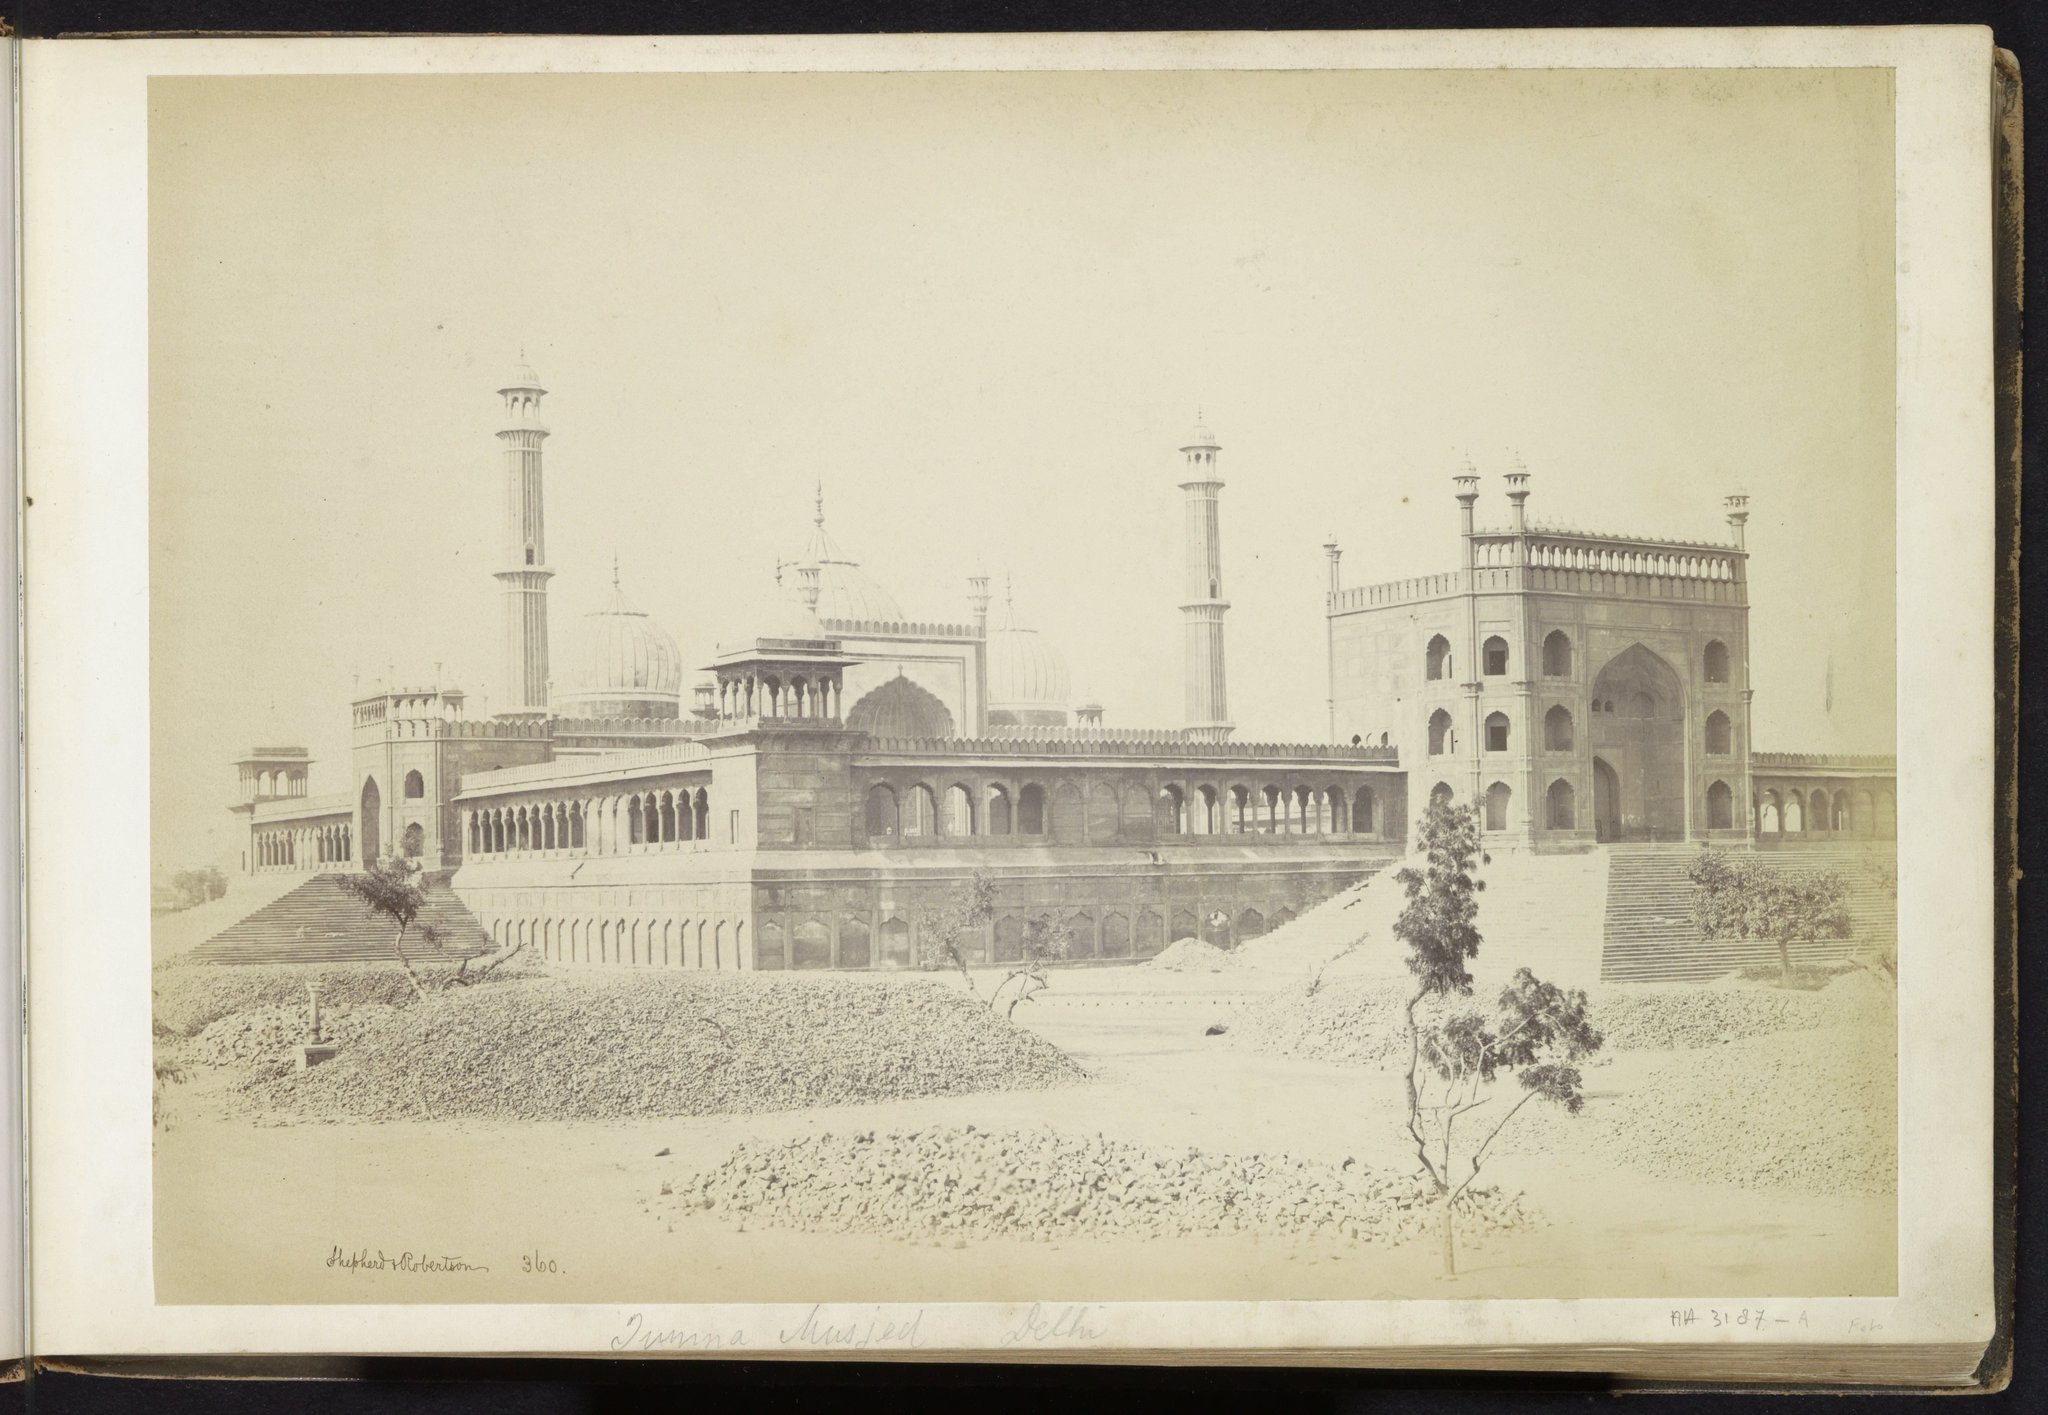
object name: album leaf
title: Exterior of Jama Masjid, Delhi, India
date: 1862-1863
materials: photographic support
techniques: albumen print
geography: delhi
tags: temple, shrine ~ islam, mohammedanism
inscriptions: title: ‘Jumma Masjid Delhi’, number: ‘360’, name: ‘Shepherd & Robertson’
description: Onderdeel van Reisalbum met opnames van bezienswaardigheden in India, Duitsland, Zwitserland en Frankrijk.